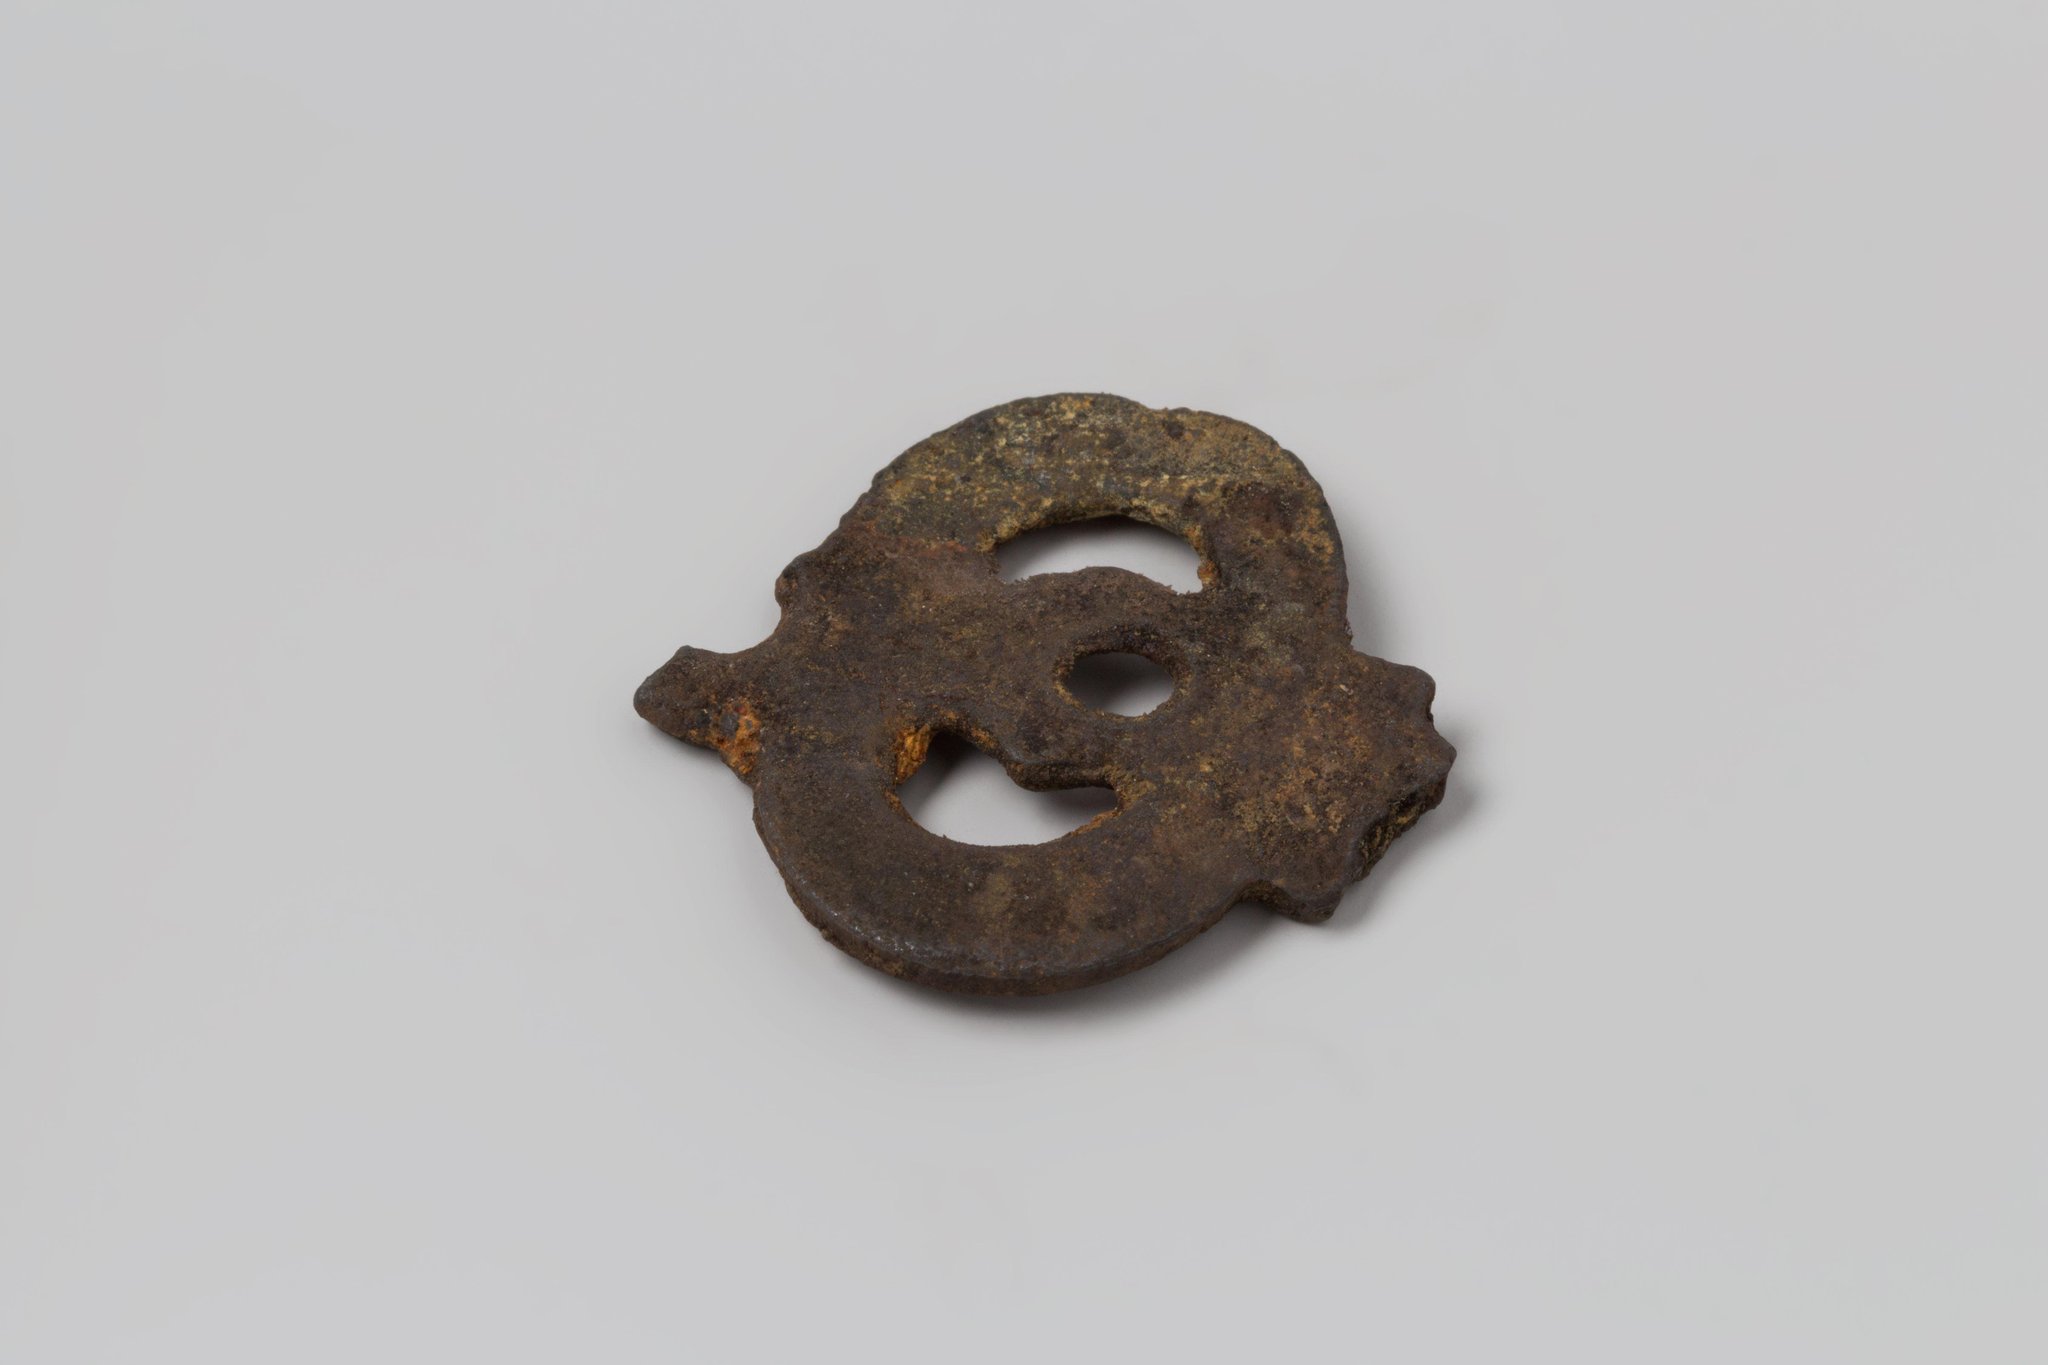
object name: hook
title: Fragment muurhaak uit het wrak van de Oost-Indiëvaarder Hollandia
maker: Anonymous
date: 1700-1743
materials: copper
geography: netherlands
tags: verenigde oostindische compagnie, hollandia (schip), annet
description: Wall hook; fragm of wall plate, id. NG 1979-213H1822, hook broken off.